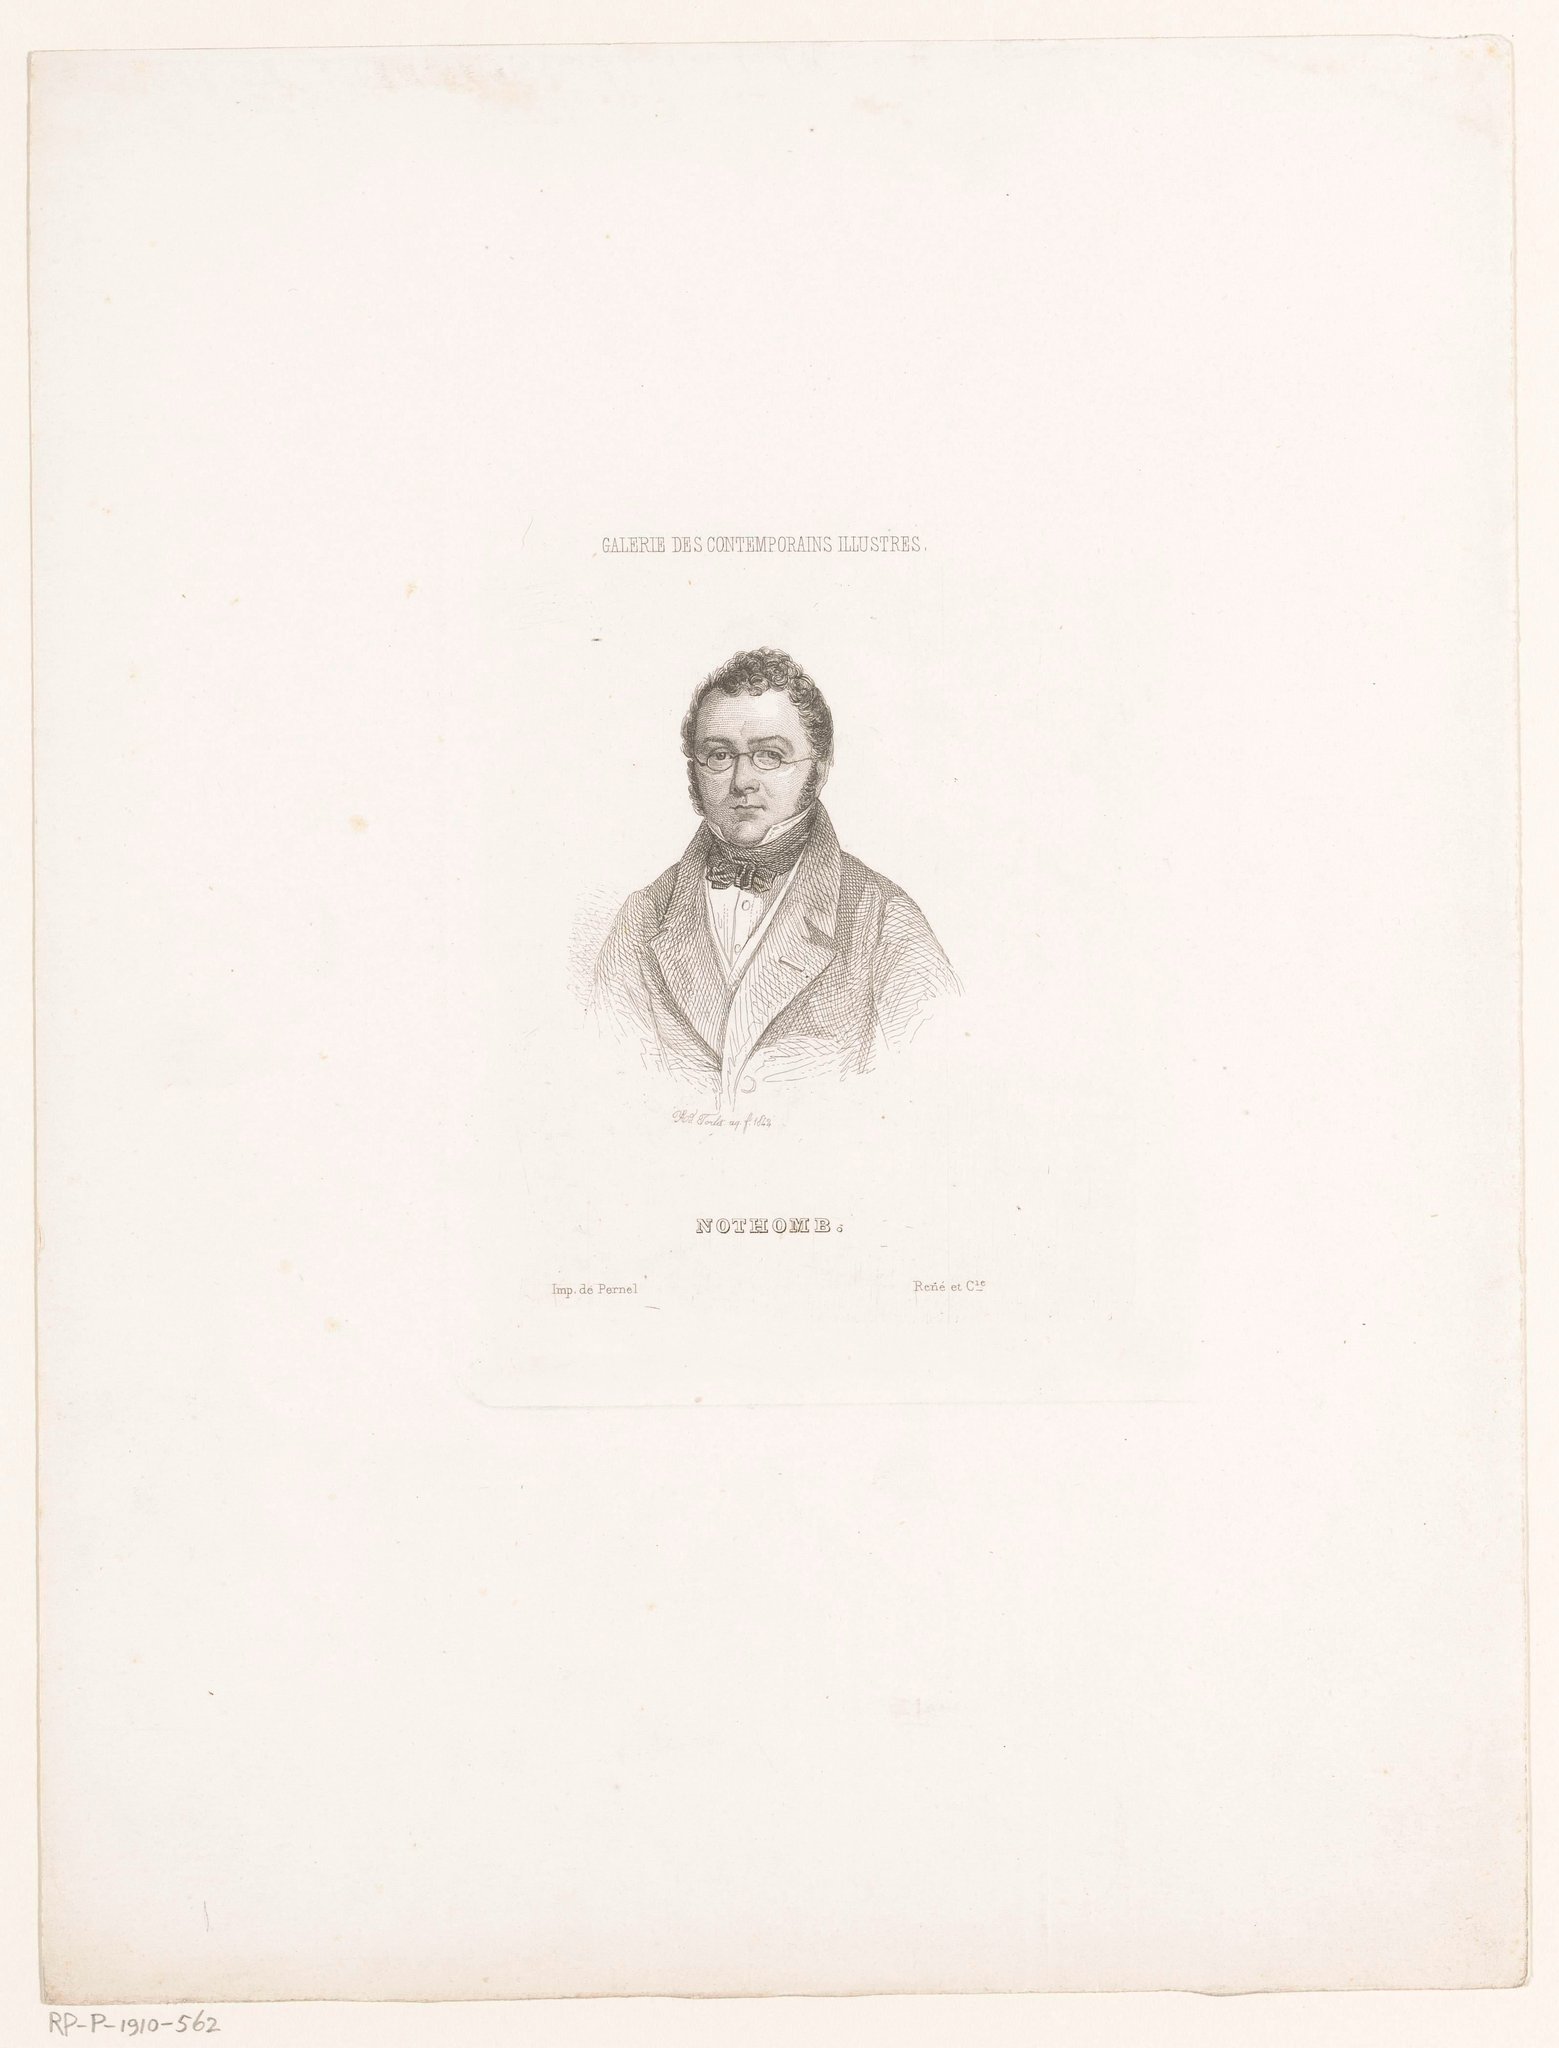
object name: print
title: Portretten van bekende tijdgenoten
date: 1843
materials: paper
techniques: etching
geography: paris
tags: berlin, historical persons, politician, e.g. party leader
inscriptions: collector's mark: Lugt 2228